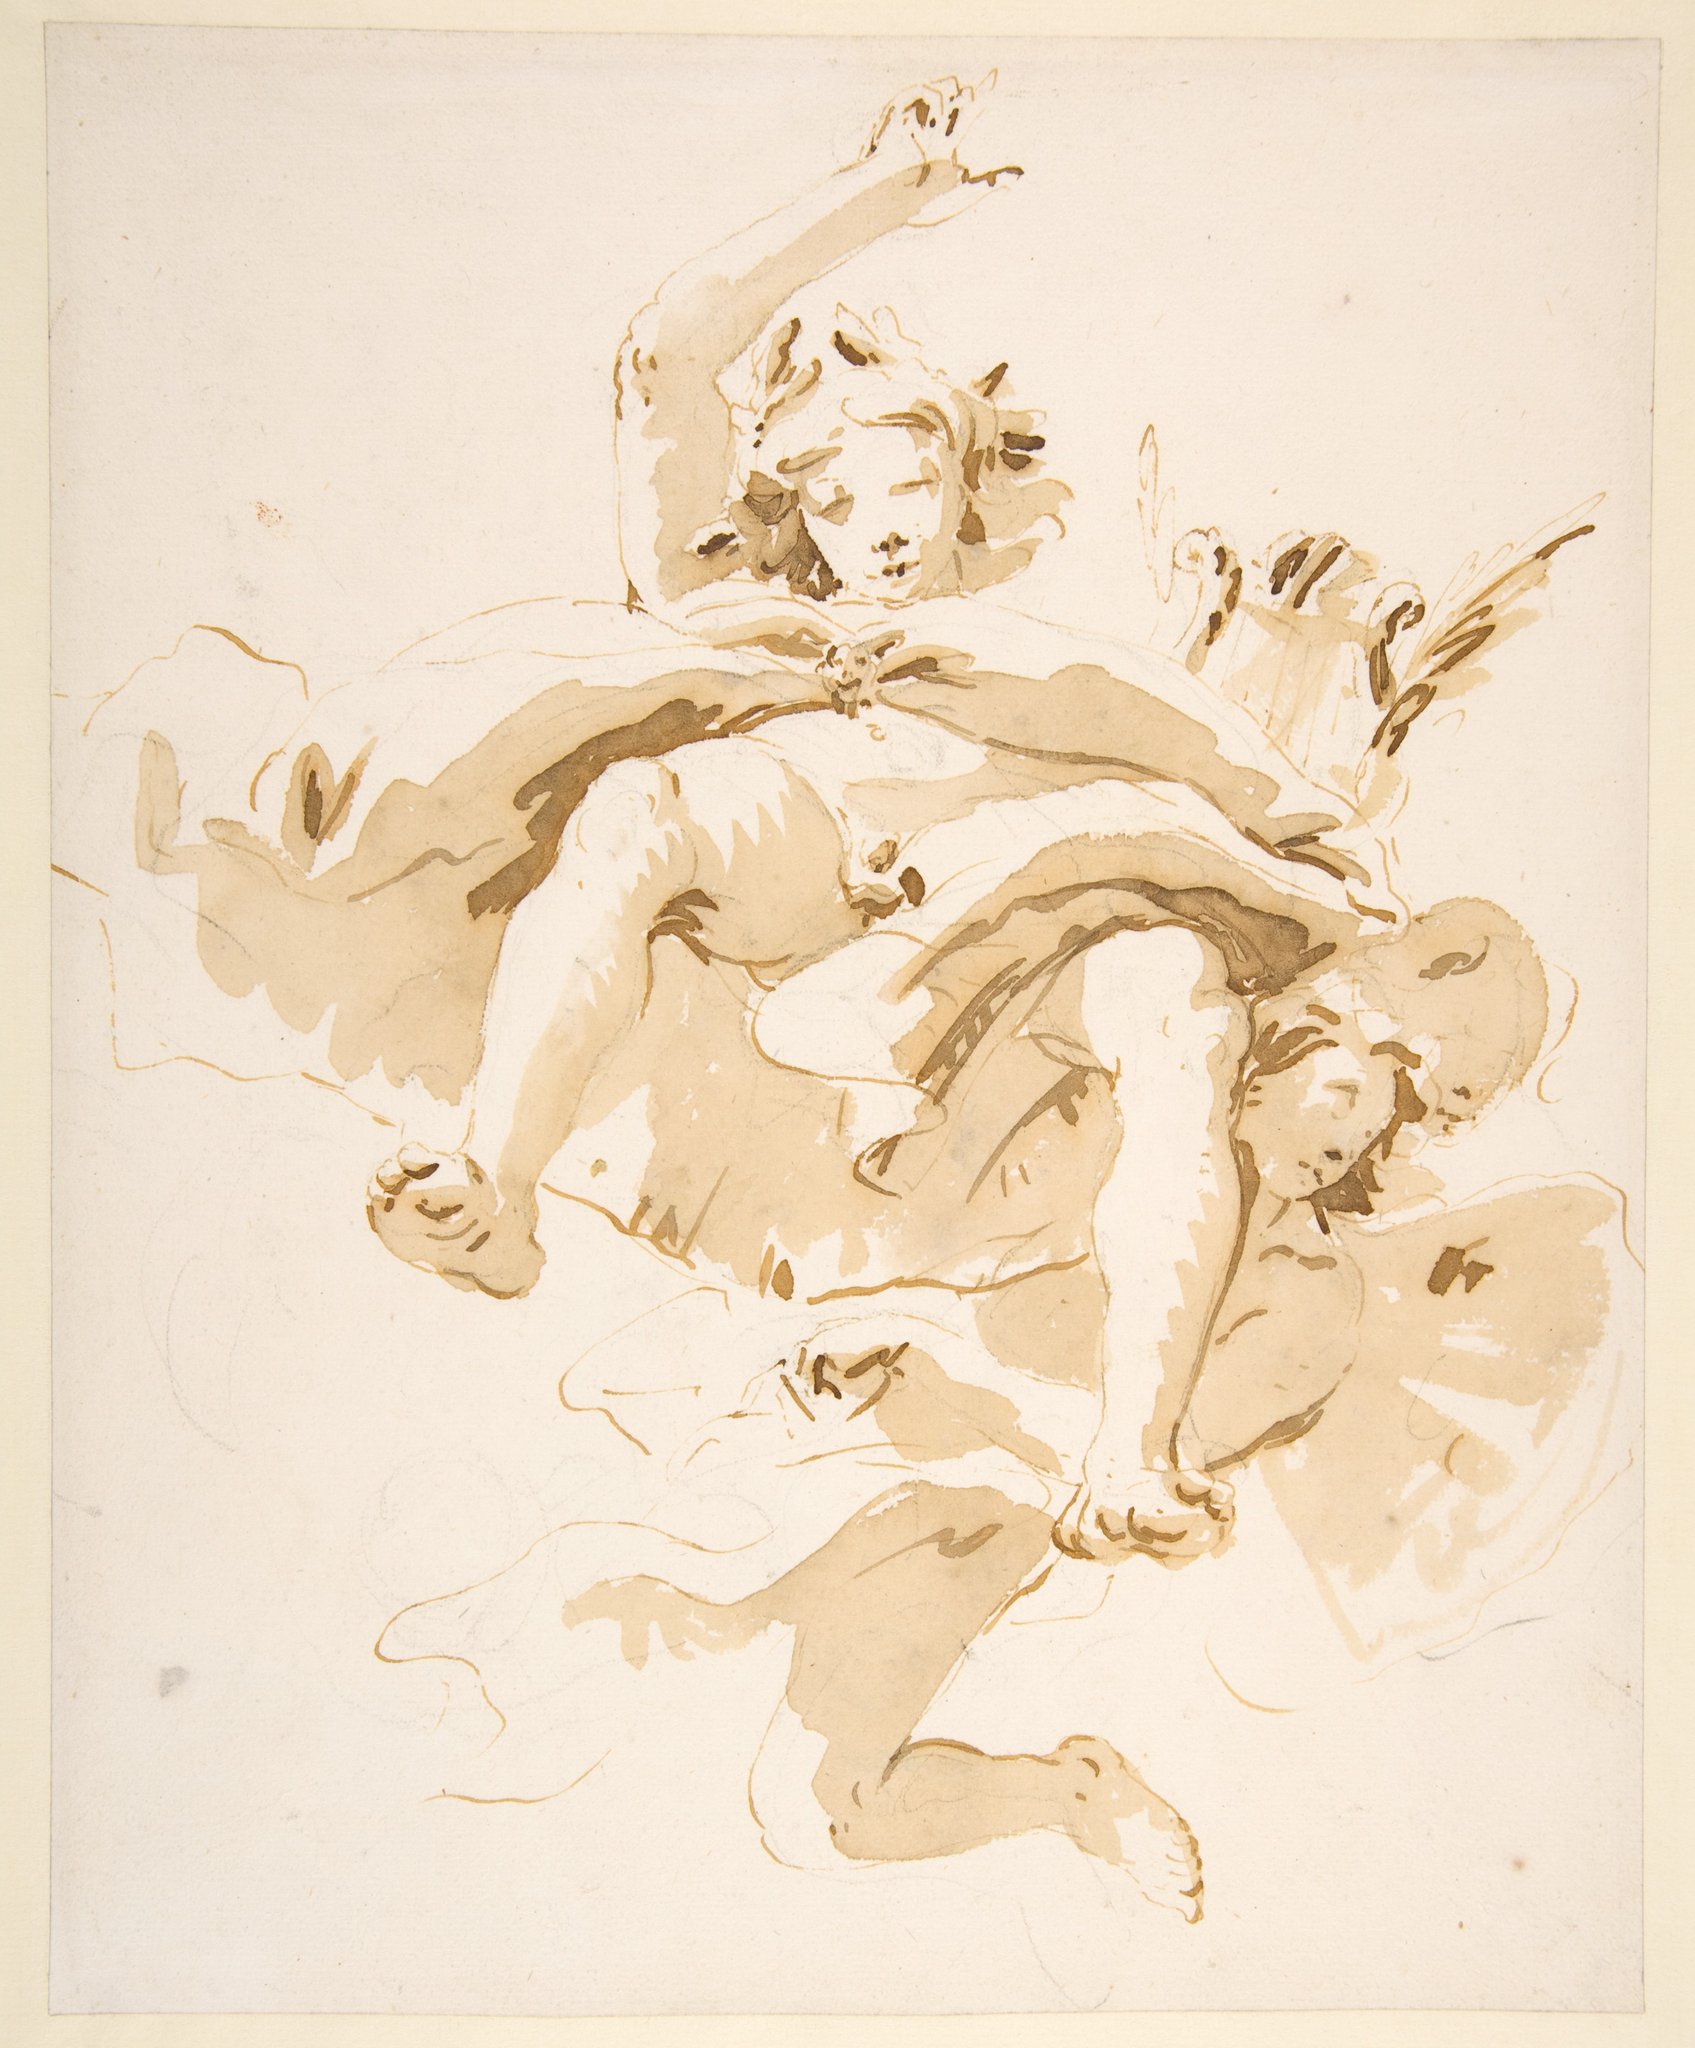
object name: drawing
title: Apollo Supported by a Winged Genius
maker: giovanni battista tiepolo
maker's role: artist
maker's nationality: italian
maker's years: 1696-1770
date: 1696-1770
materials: chalk, ink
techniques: brush, pen, wash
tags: apollo